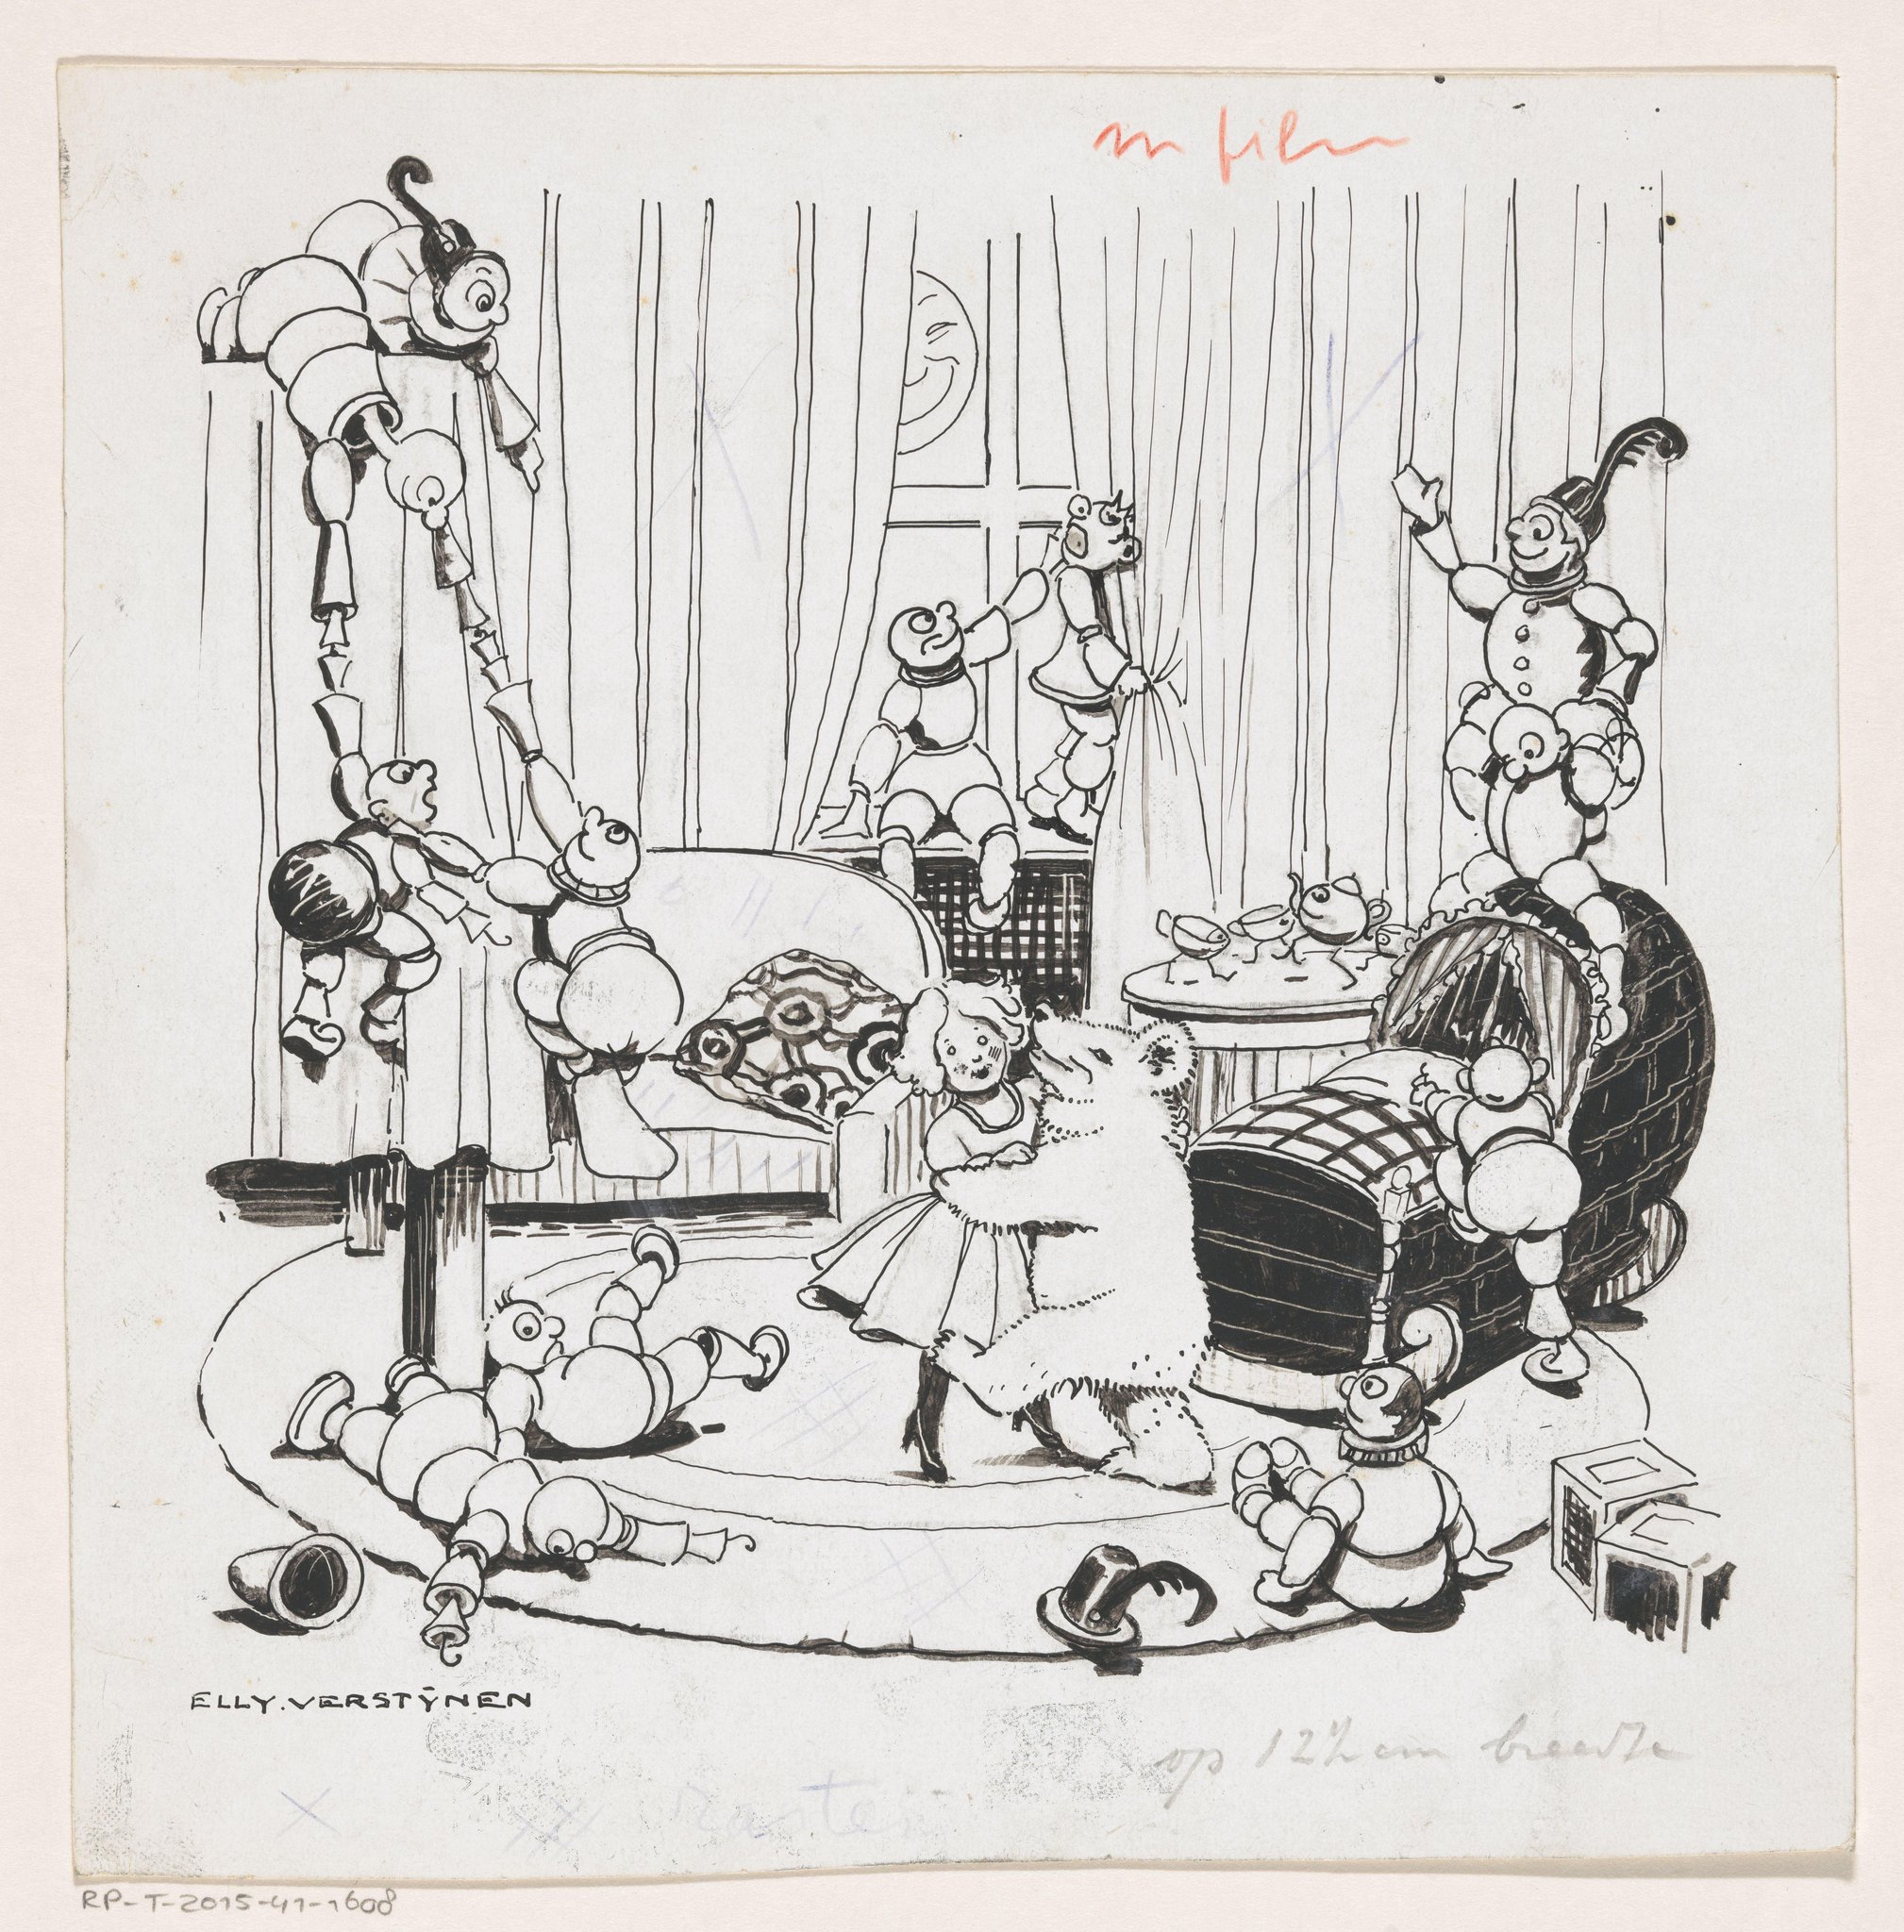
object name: drawing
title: Feestvierend speelgoed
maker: elly verstijnen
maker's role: draughtsman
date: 1900-1930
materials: ink, paper, pencil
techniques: brush, pen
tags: (playing with) toy animals, (playing with) dolls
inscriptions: signature: ‘ELLY. VERSTIJNEN’, collector's mark: Lugt 2228, :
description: In een kamer zijn verschillende soorten speelgoed tot leven gekomen en feest aan het vieren. Een pop danst met een knuffelbeer en poppen klimmen in de gordijnen en klauteren over een poppenwieg. Een theeservies danst op een bijzettafel.